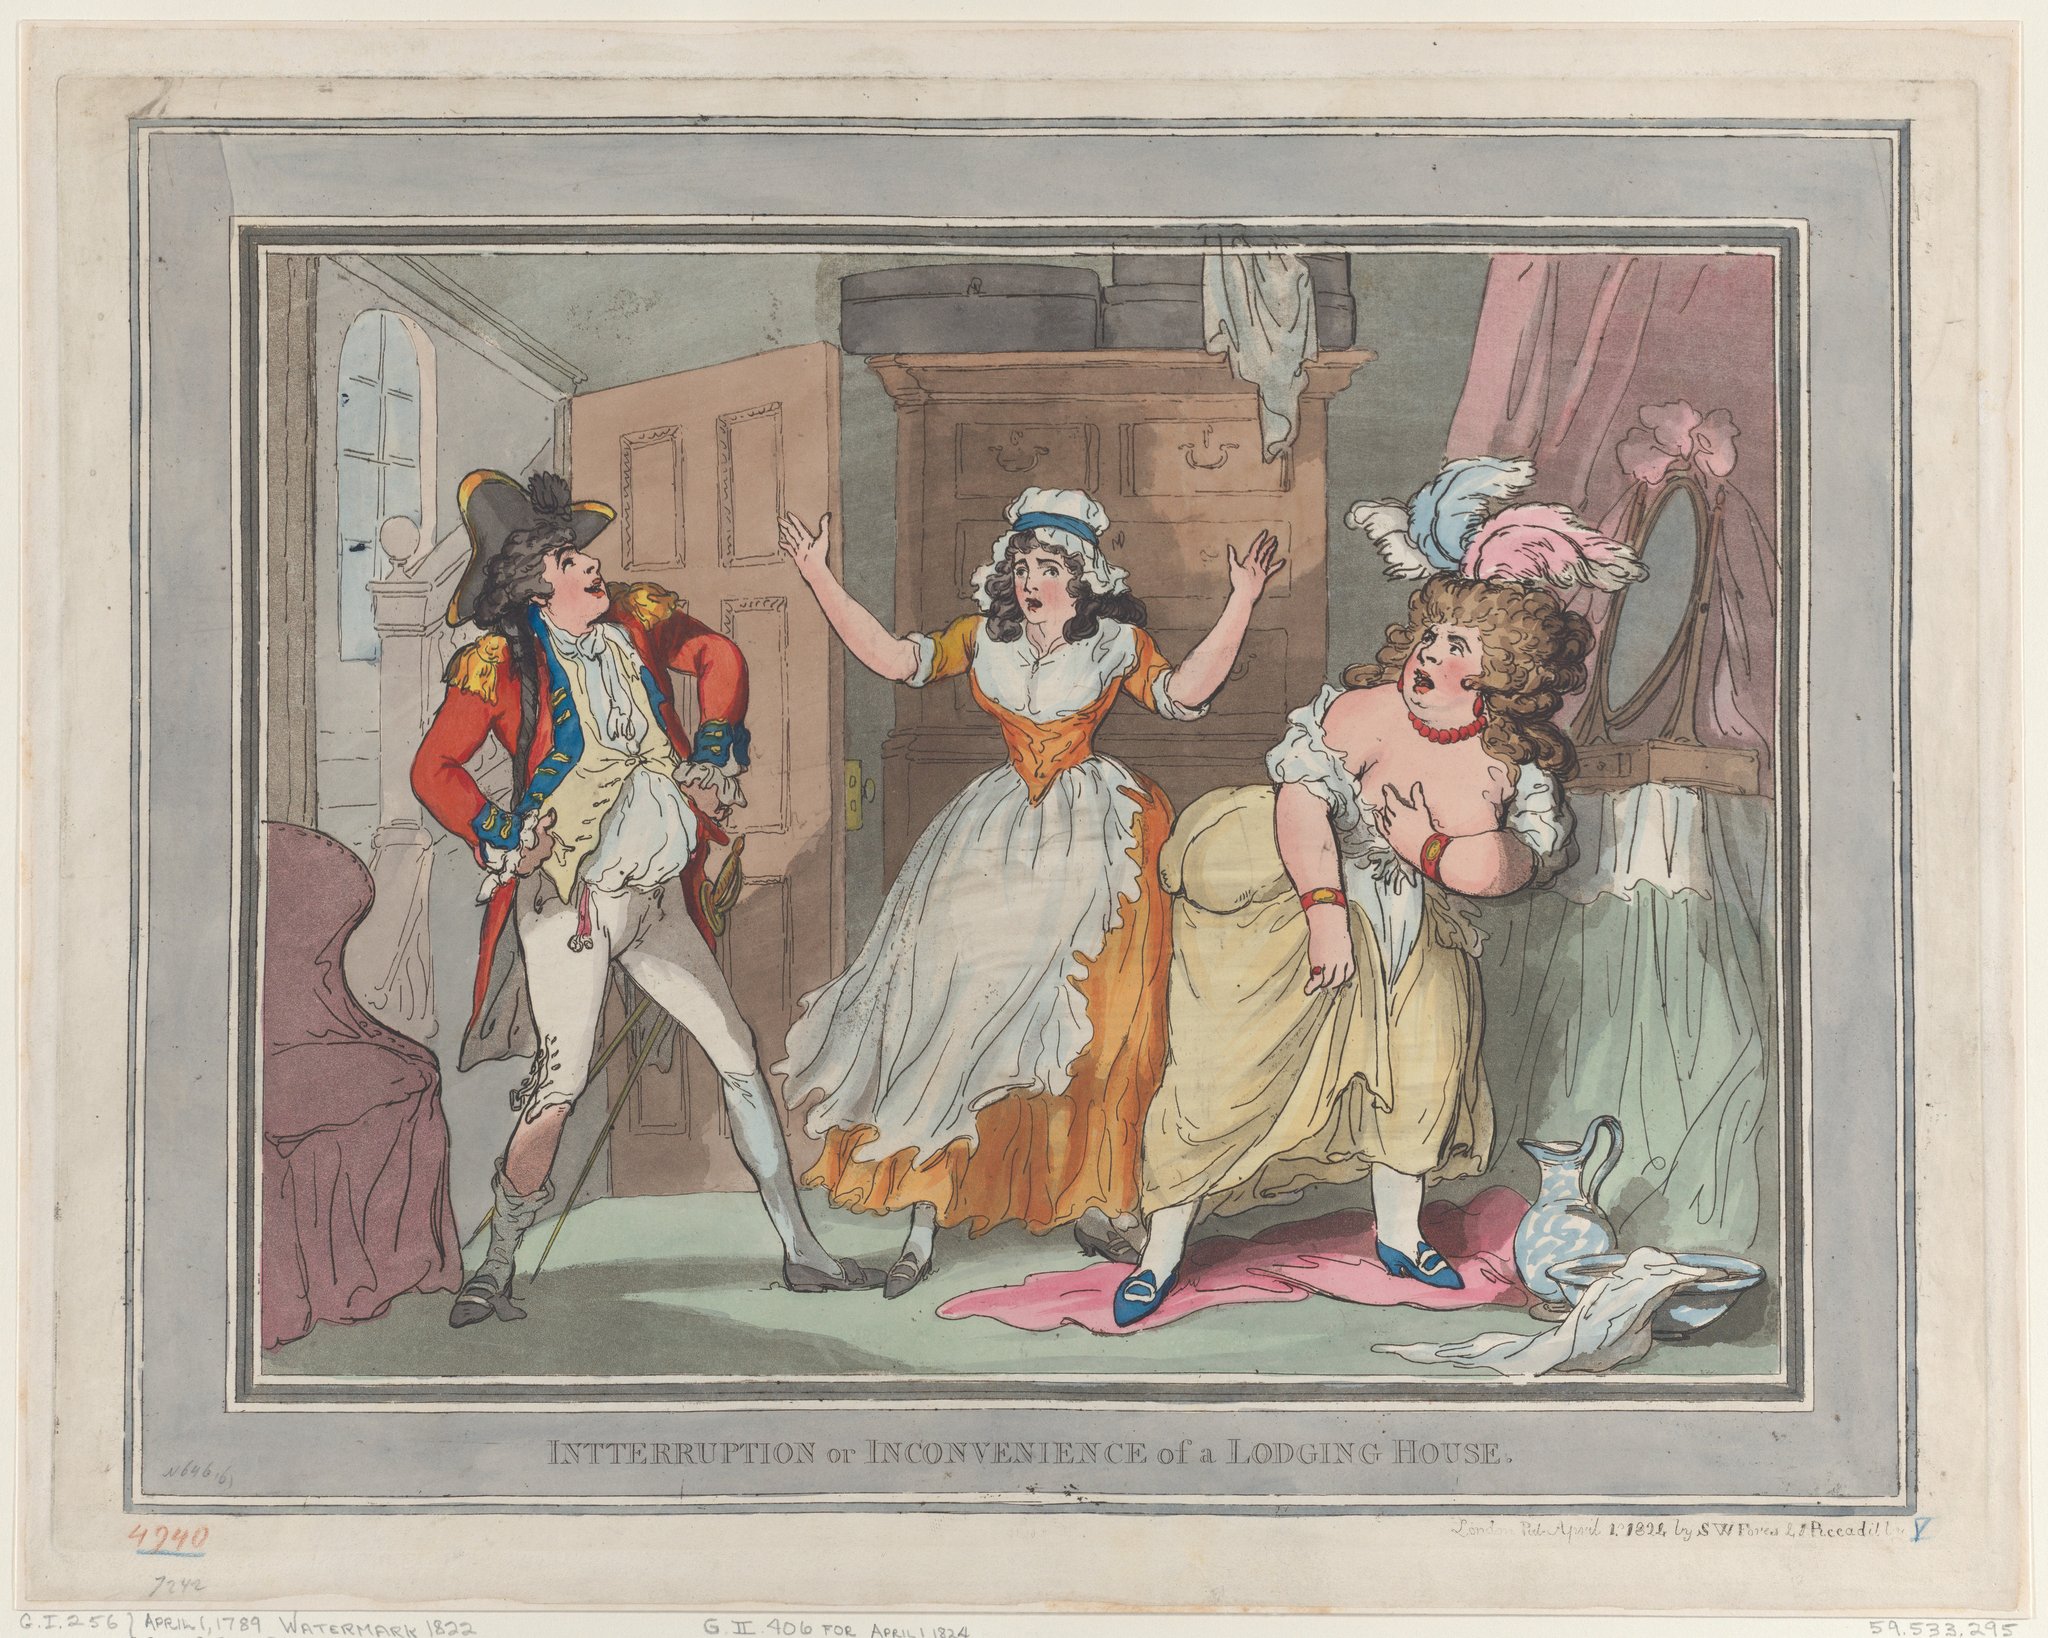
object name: print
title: Interruption or Inconvenience of a Lodging House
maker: thomas rowlandson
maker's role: artist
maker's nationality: british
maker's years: 1757-1827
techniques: etching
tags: satire,men,women